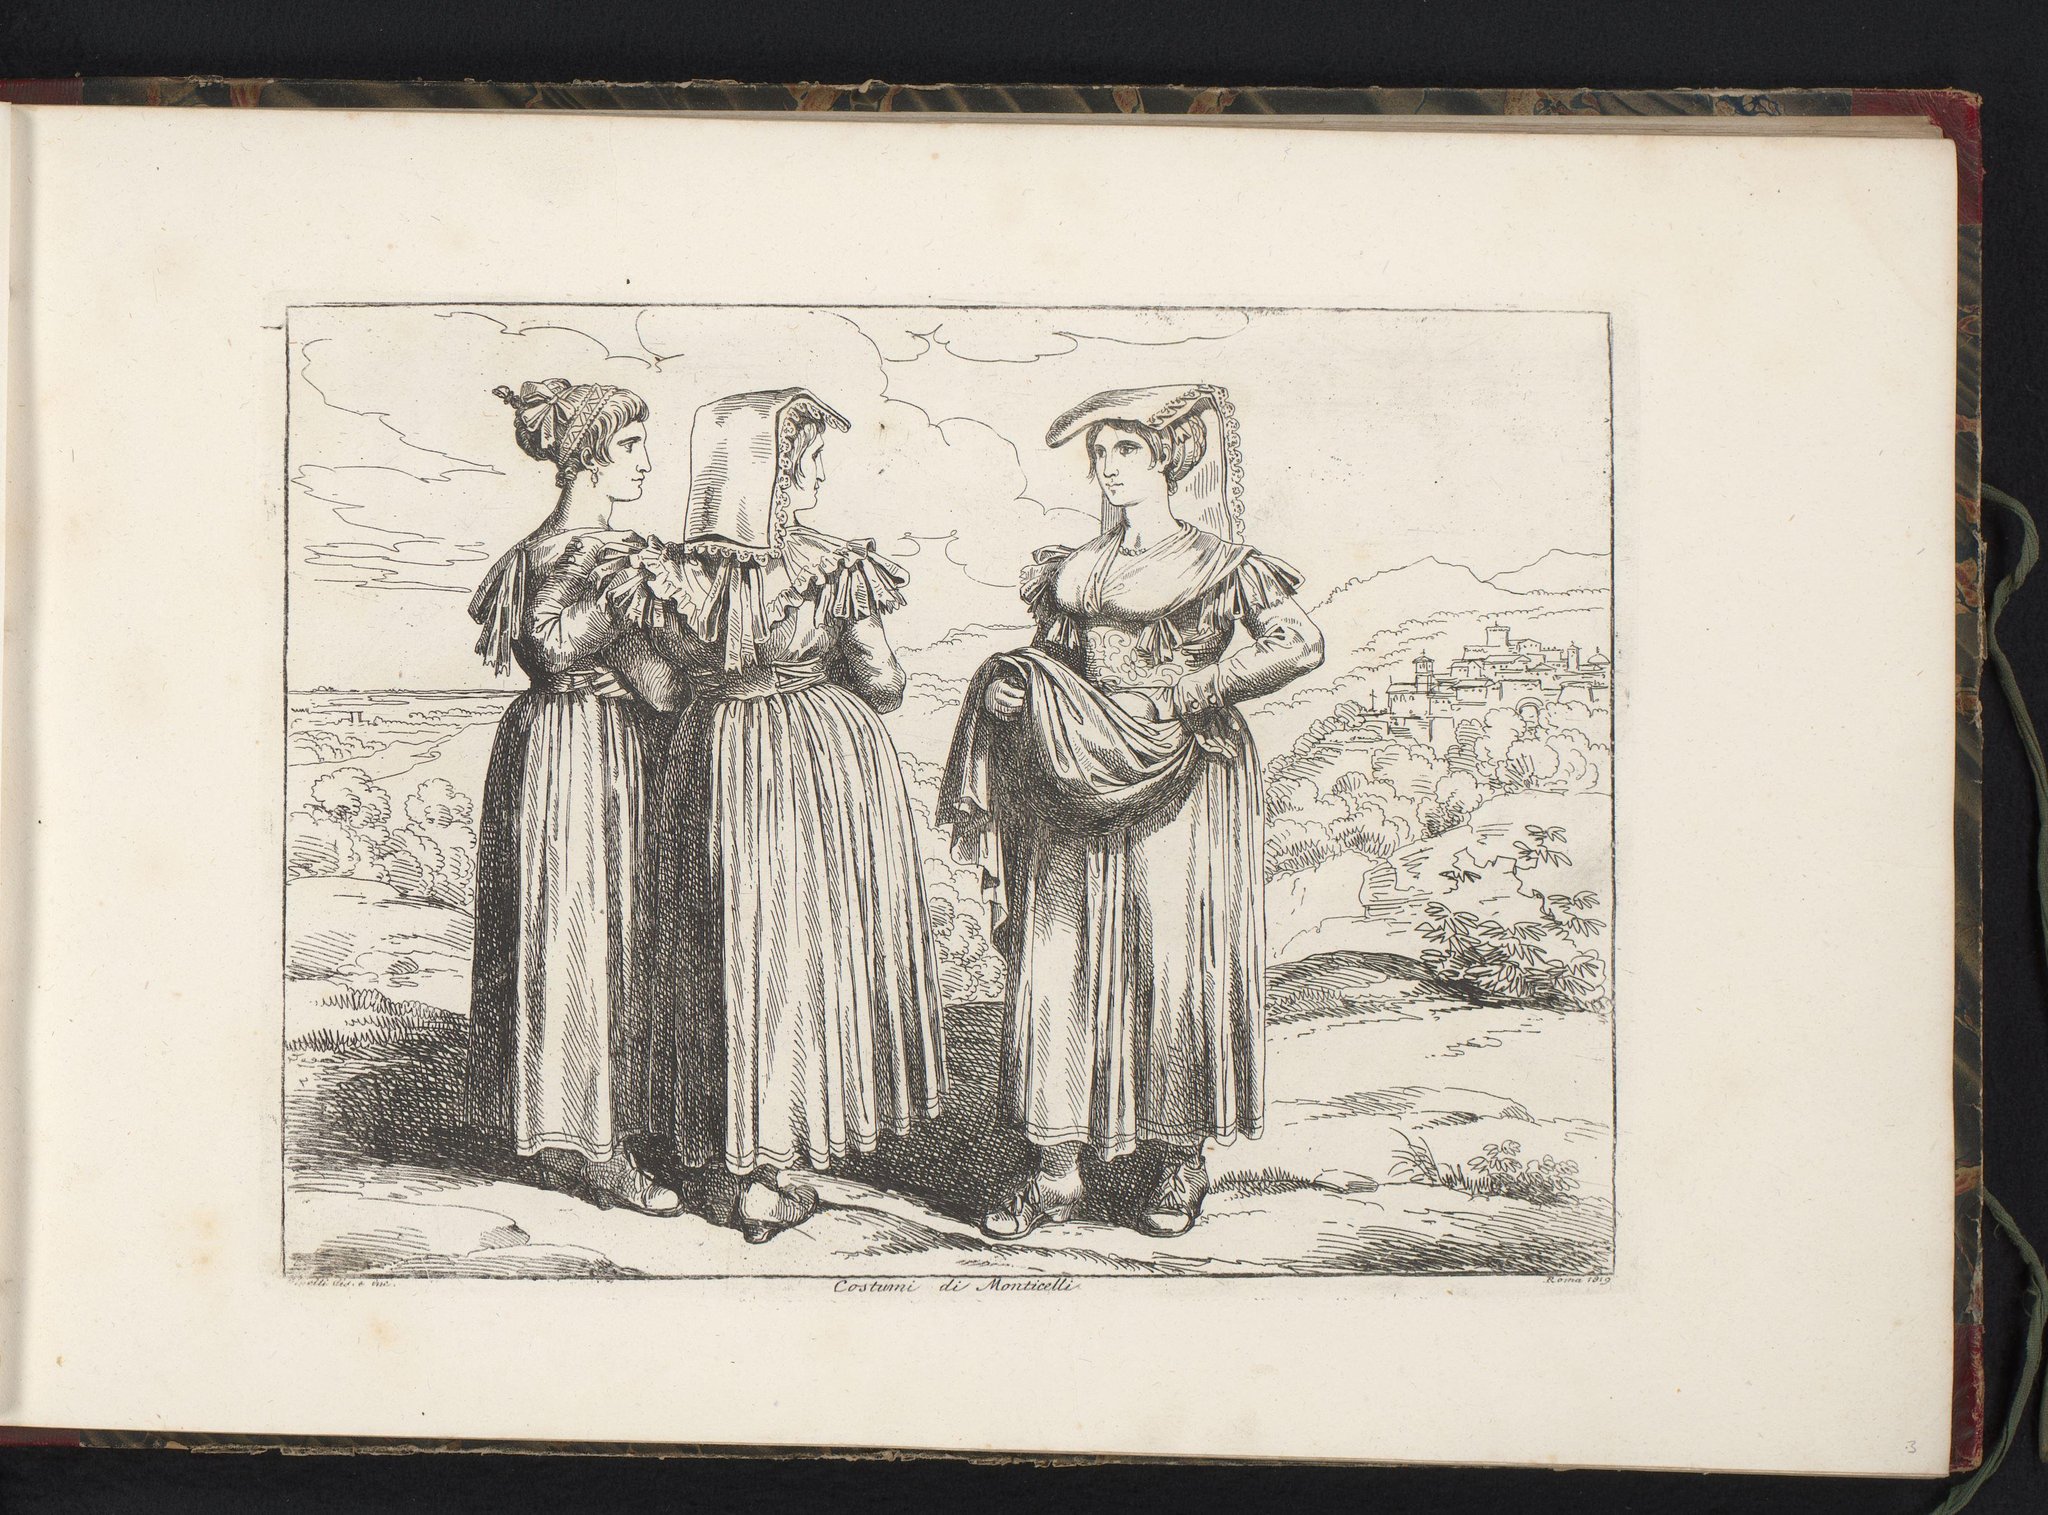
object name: album leaf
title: Nuova raccolta di cinquanta costumi de contorni di Roma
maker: bartolomeo pinelli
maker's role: draughtsman, print maker, sculptor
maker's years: 1781-1835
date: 1819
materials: paper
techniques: etching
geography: rome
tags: city-view, and landscape with man-made constructions, folk costume, regional costume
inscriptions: date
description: Deze prent maakt deel uit van een serie van 50 prenten. De serie bestaat uit kostuumprenten en voorstellingen van bandieten.